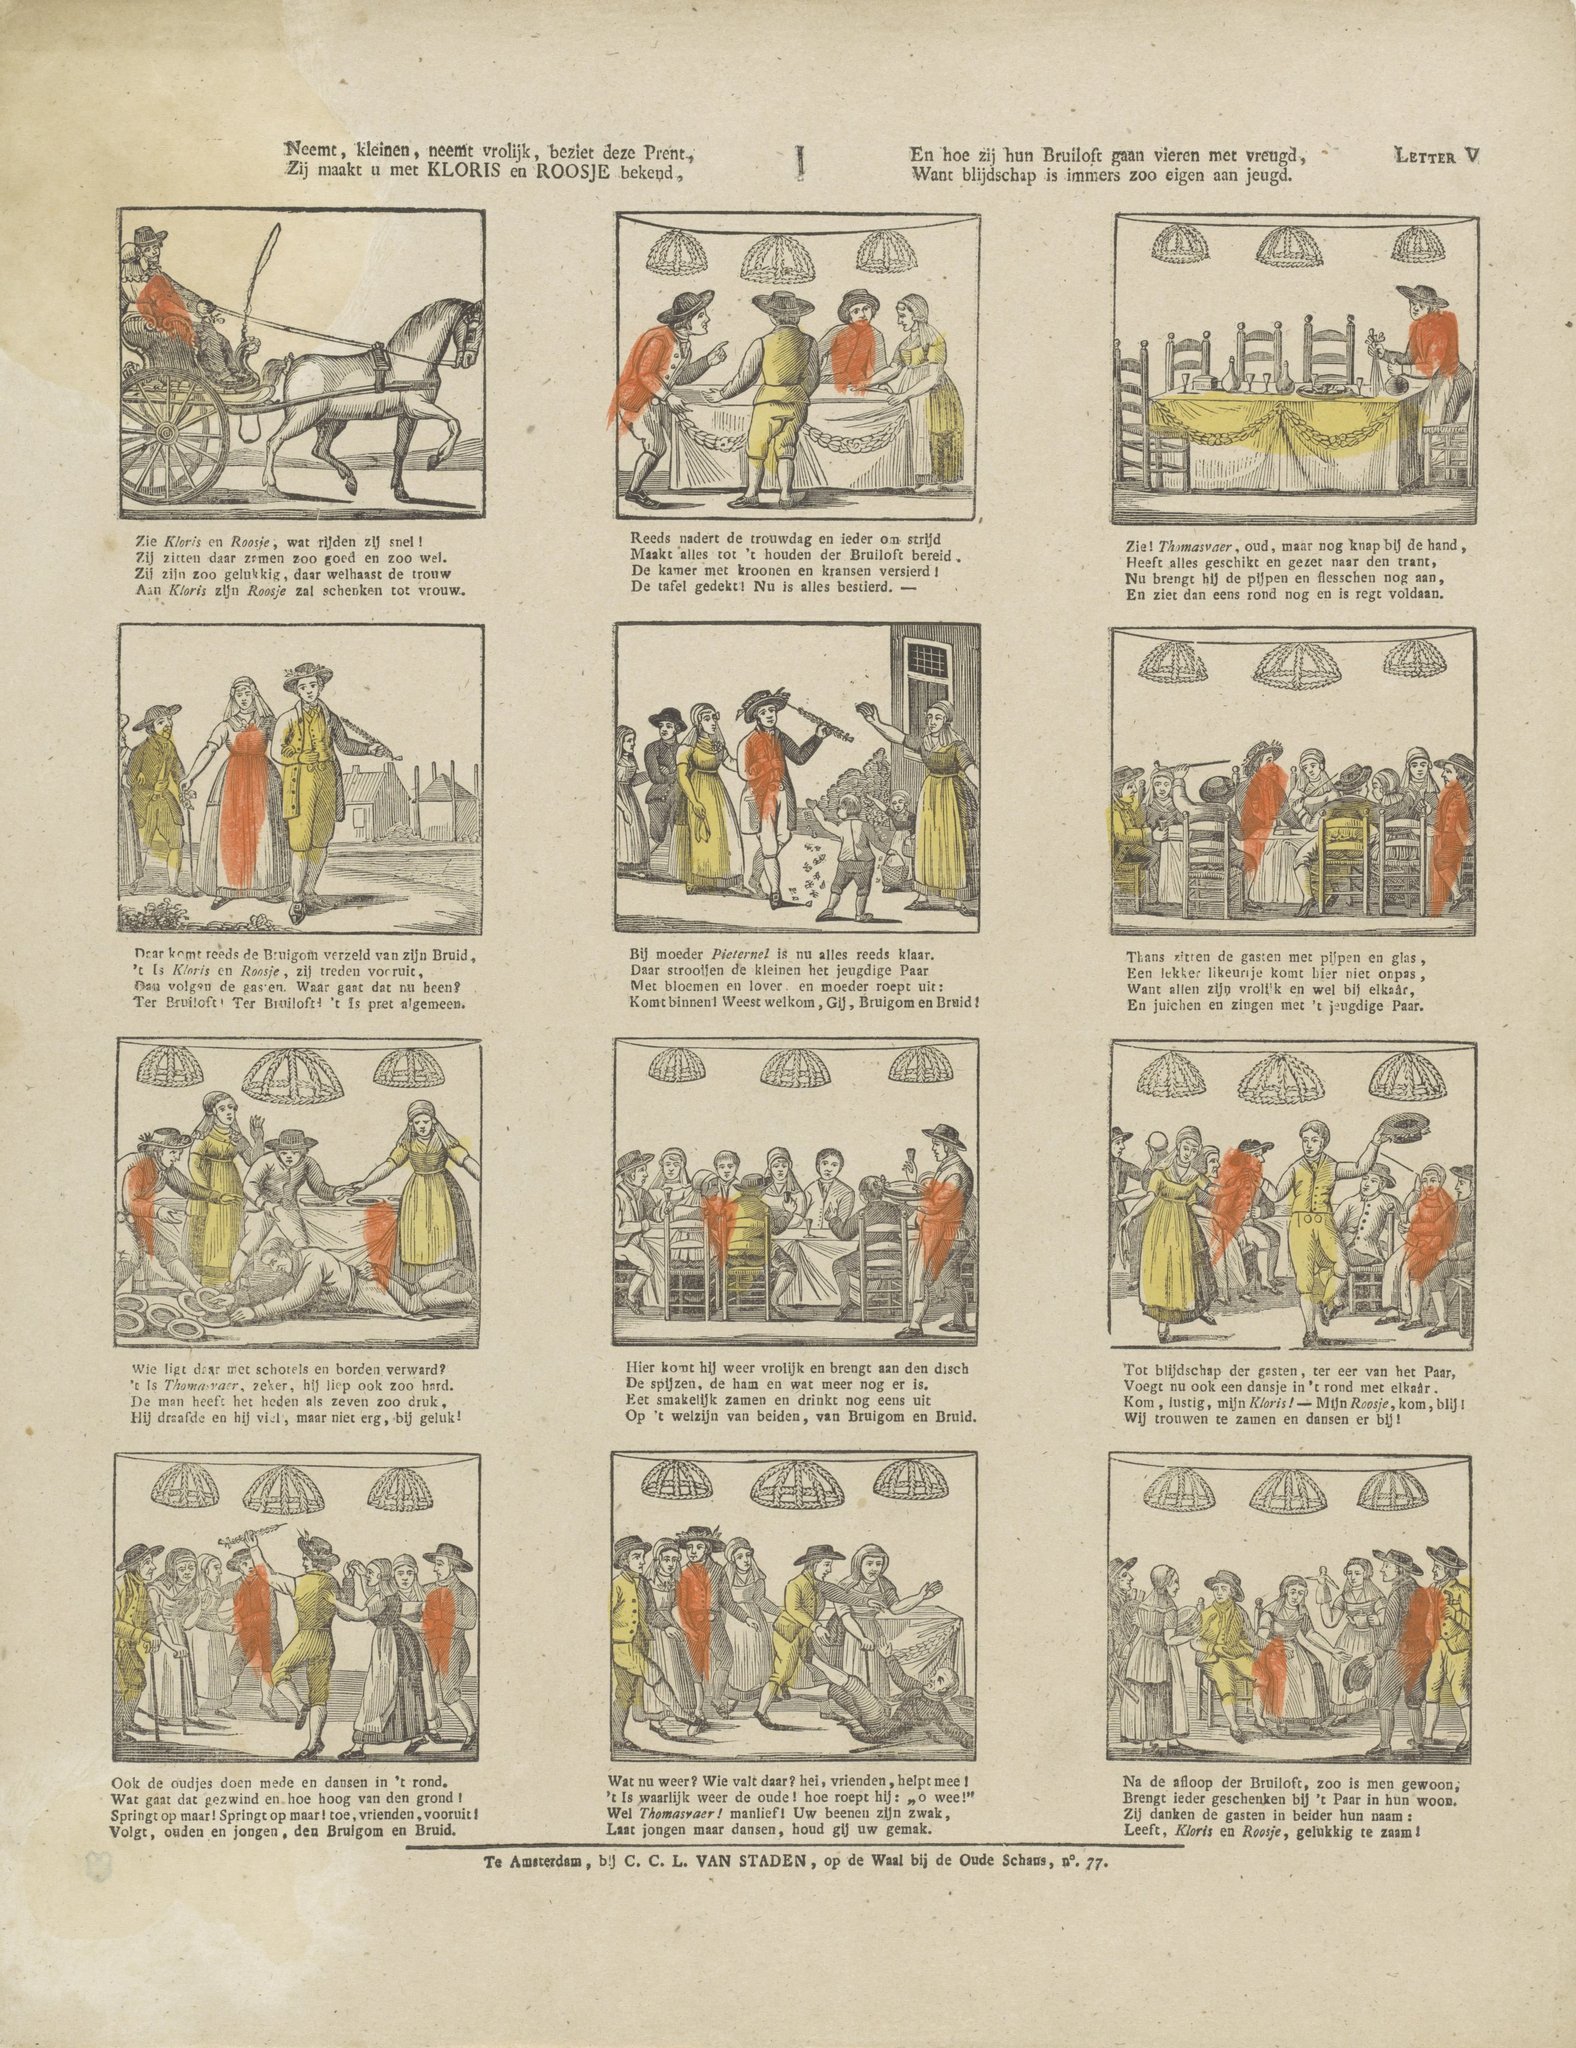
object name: print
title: Neemt, kleinen, neemt vrolijk, beziet deze prent, / Zij maakt u met Kloris en Roosje bekend, / En hoe zij hun bruiloft gaan vieren met vreugd, / Want blijdschap is immers zoo eigen aan jeugd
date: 1822-1870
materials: paper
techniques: colour, letterpress printing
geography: amsterdam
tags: wedding feast, wedding meal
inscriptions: collector's mark: Lugt 2760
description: Blad met 12 voorstellingen over de bruiloft van Kloris en Roosje. Onder elke afbeelding een vierregelig vers. Rechtsboven gemerkt: Letter V.